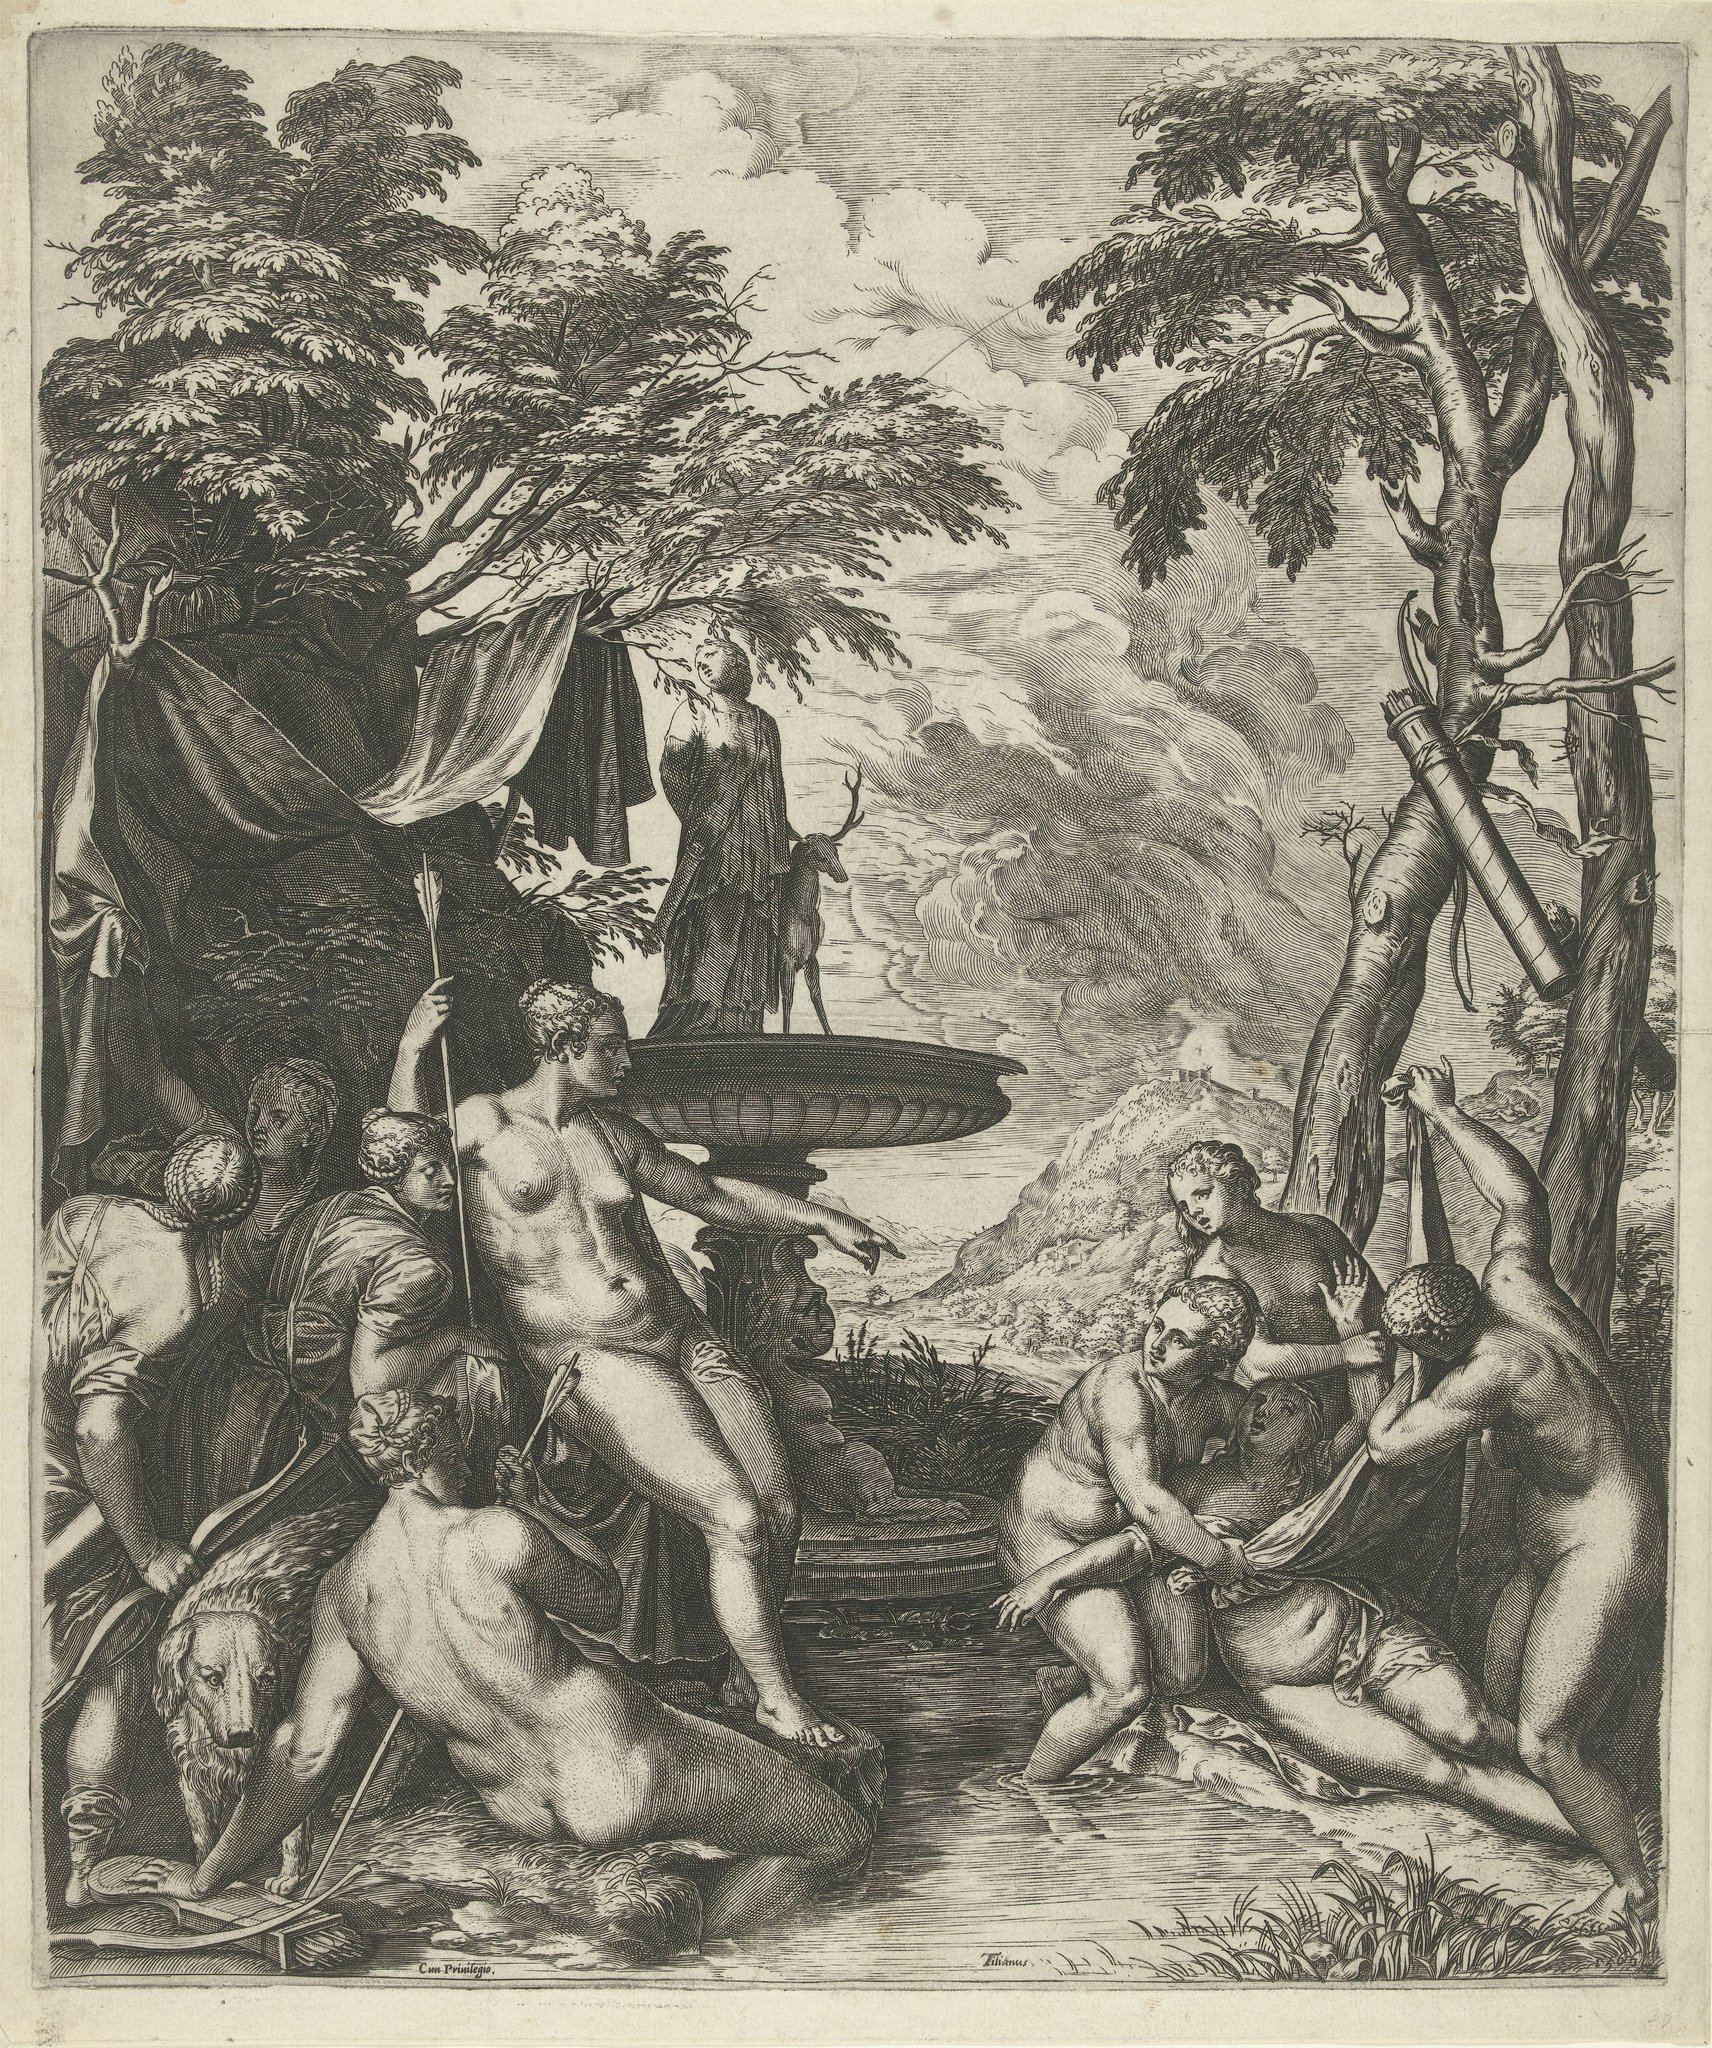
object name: print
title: Diana ontdekt de zwangerschap van Callisto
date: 1566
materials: paper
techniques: engraving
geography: rome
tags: diana with her nymphs discovers the pregnancy of callisto, pregnancy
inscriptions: collector's mark: Lugt 240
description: Diana neemt samen met haar nimfen een bad. Ze ontdekt verontrust dat haar nimf Callisto zwanger is. Op de achtergrond een fontein met een beeld van Diana met een hert.